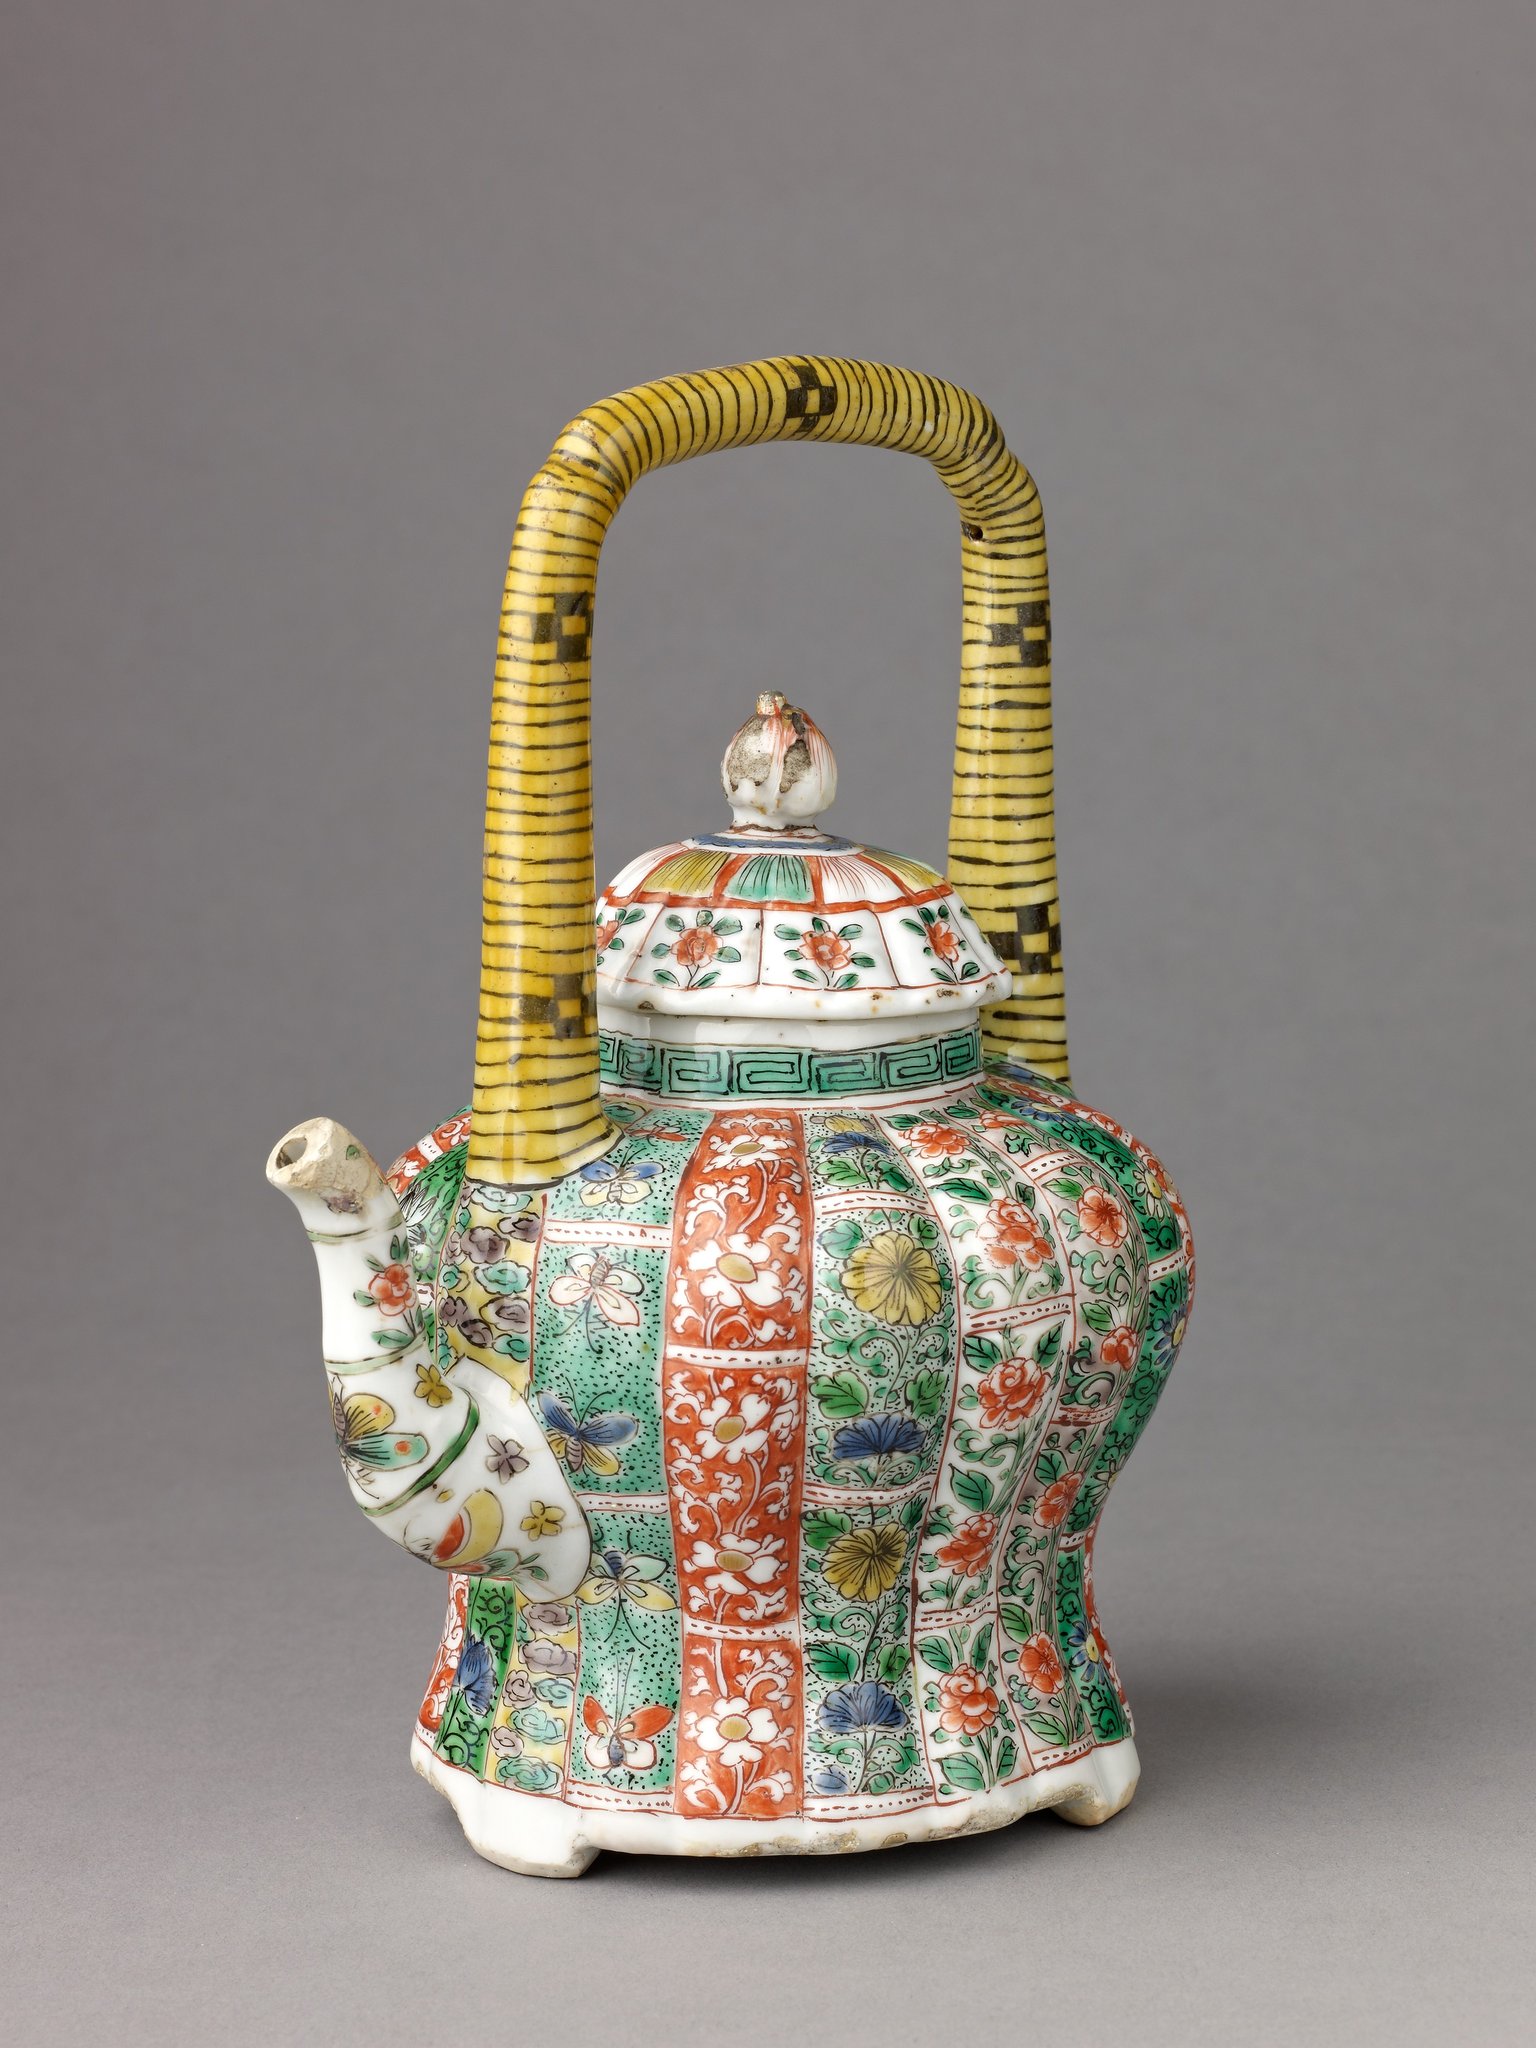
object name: covered winepot or teapot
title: Covered wine pot or teapot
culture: chinese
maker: chinese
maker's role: artist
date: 1662-1722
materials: enamel, gilt, porcelain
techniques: overglaze, painting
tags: butterflies,flowers